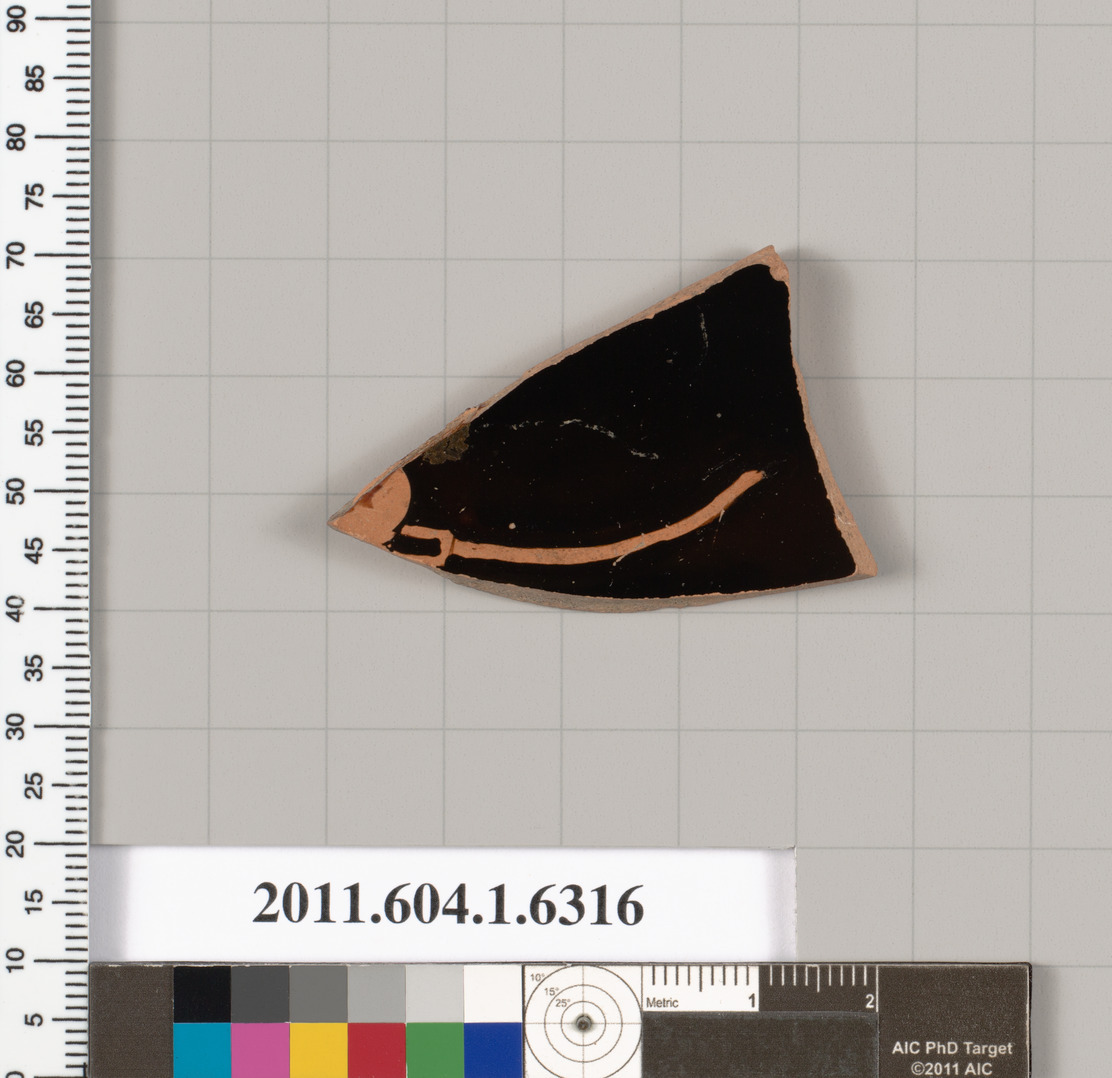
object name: kylix fragment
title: Terracotta fragment of a kylix (drinking cup)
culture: greek, attic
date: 500-480 BCE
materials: terracotta